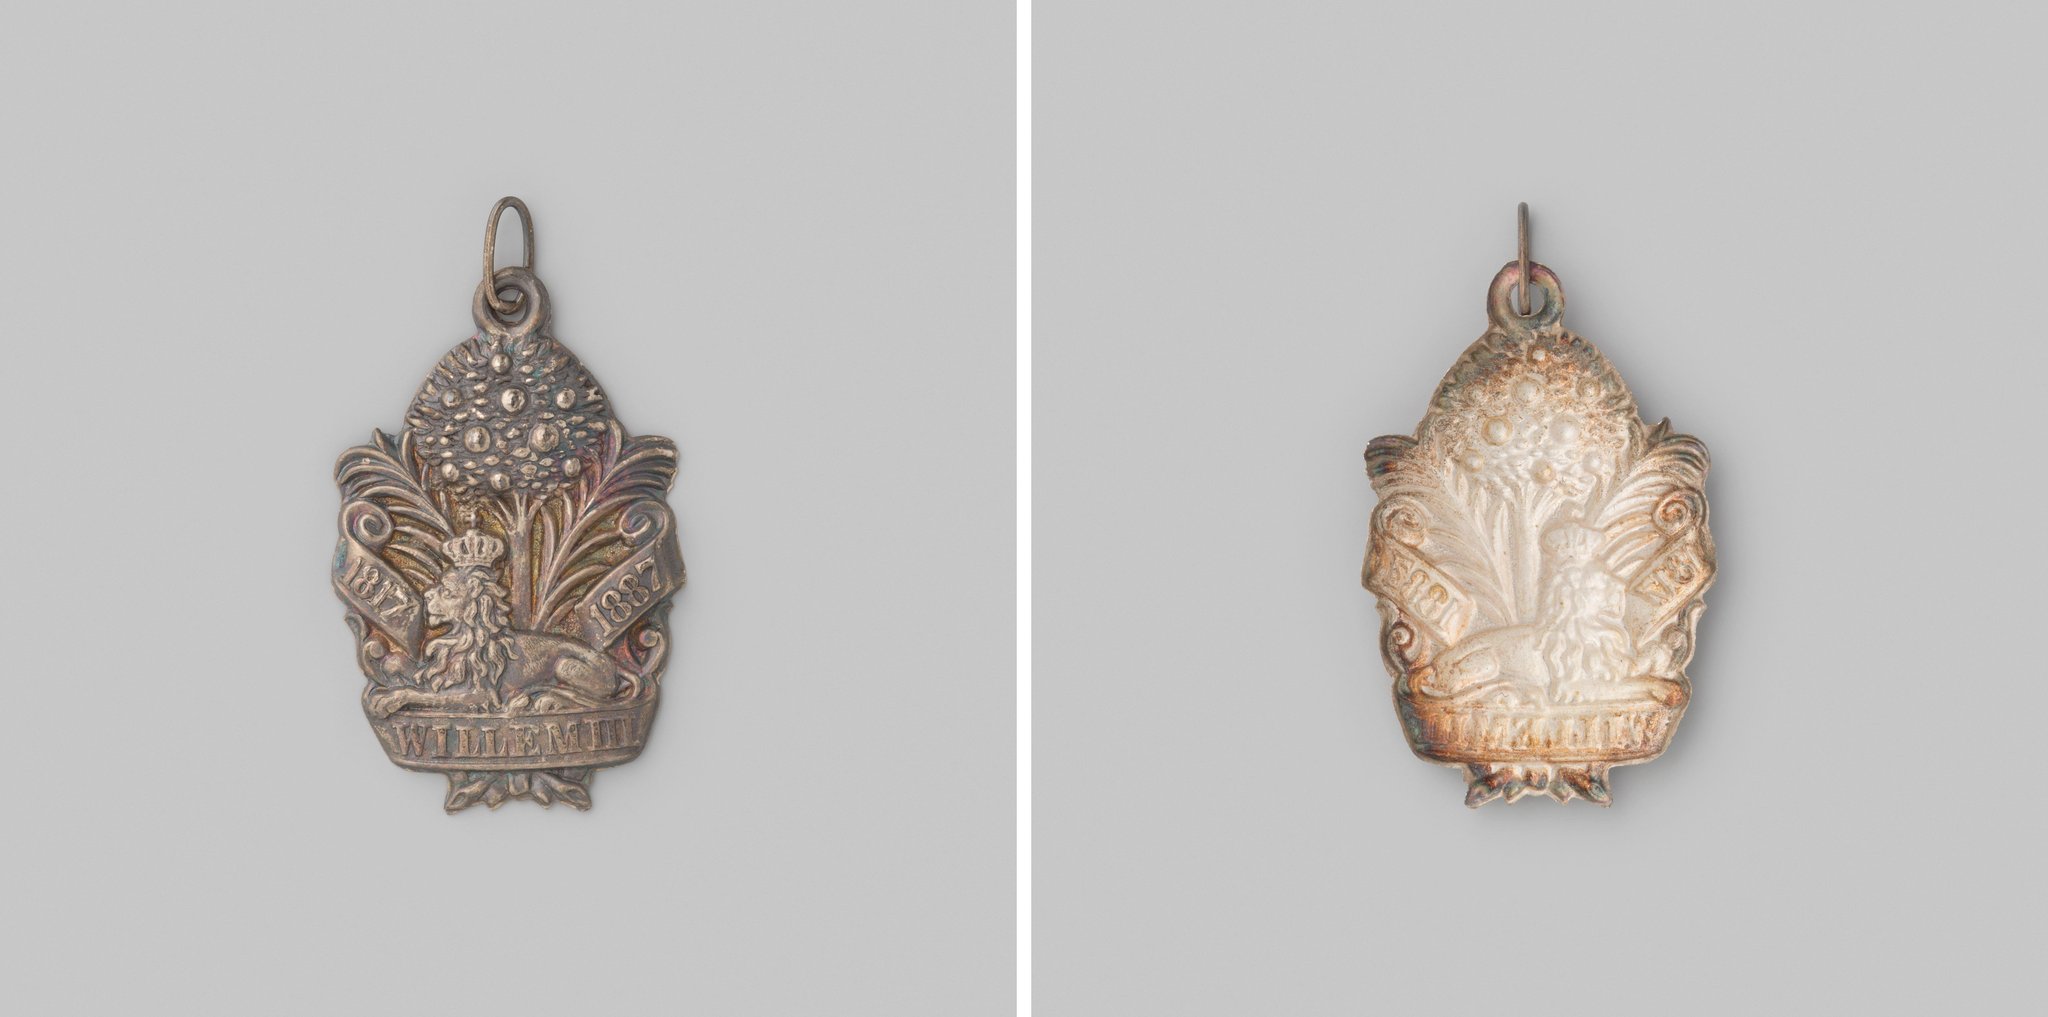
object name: history medal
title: Zeventigste verjaardag van Koning Willem III 1887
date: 1887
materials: silver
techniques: pressing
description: Eenzijdig zilveren draagteken met oog en draagring, een gekroonde leeuw liggend naar links, op een tekstlint, onder een oranjeboom en twee palmtakken.